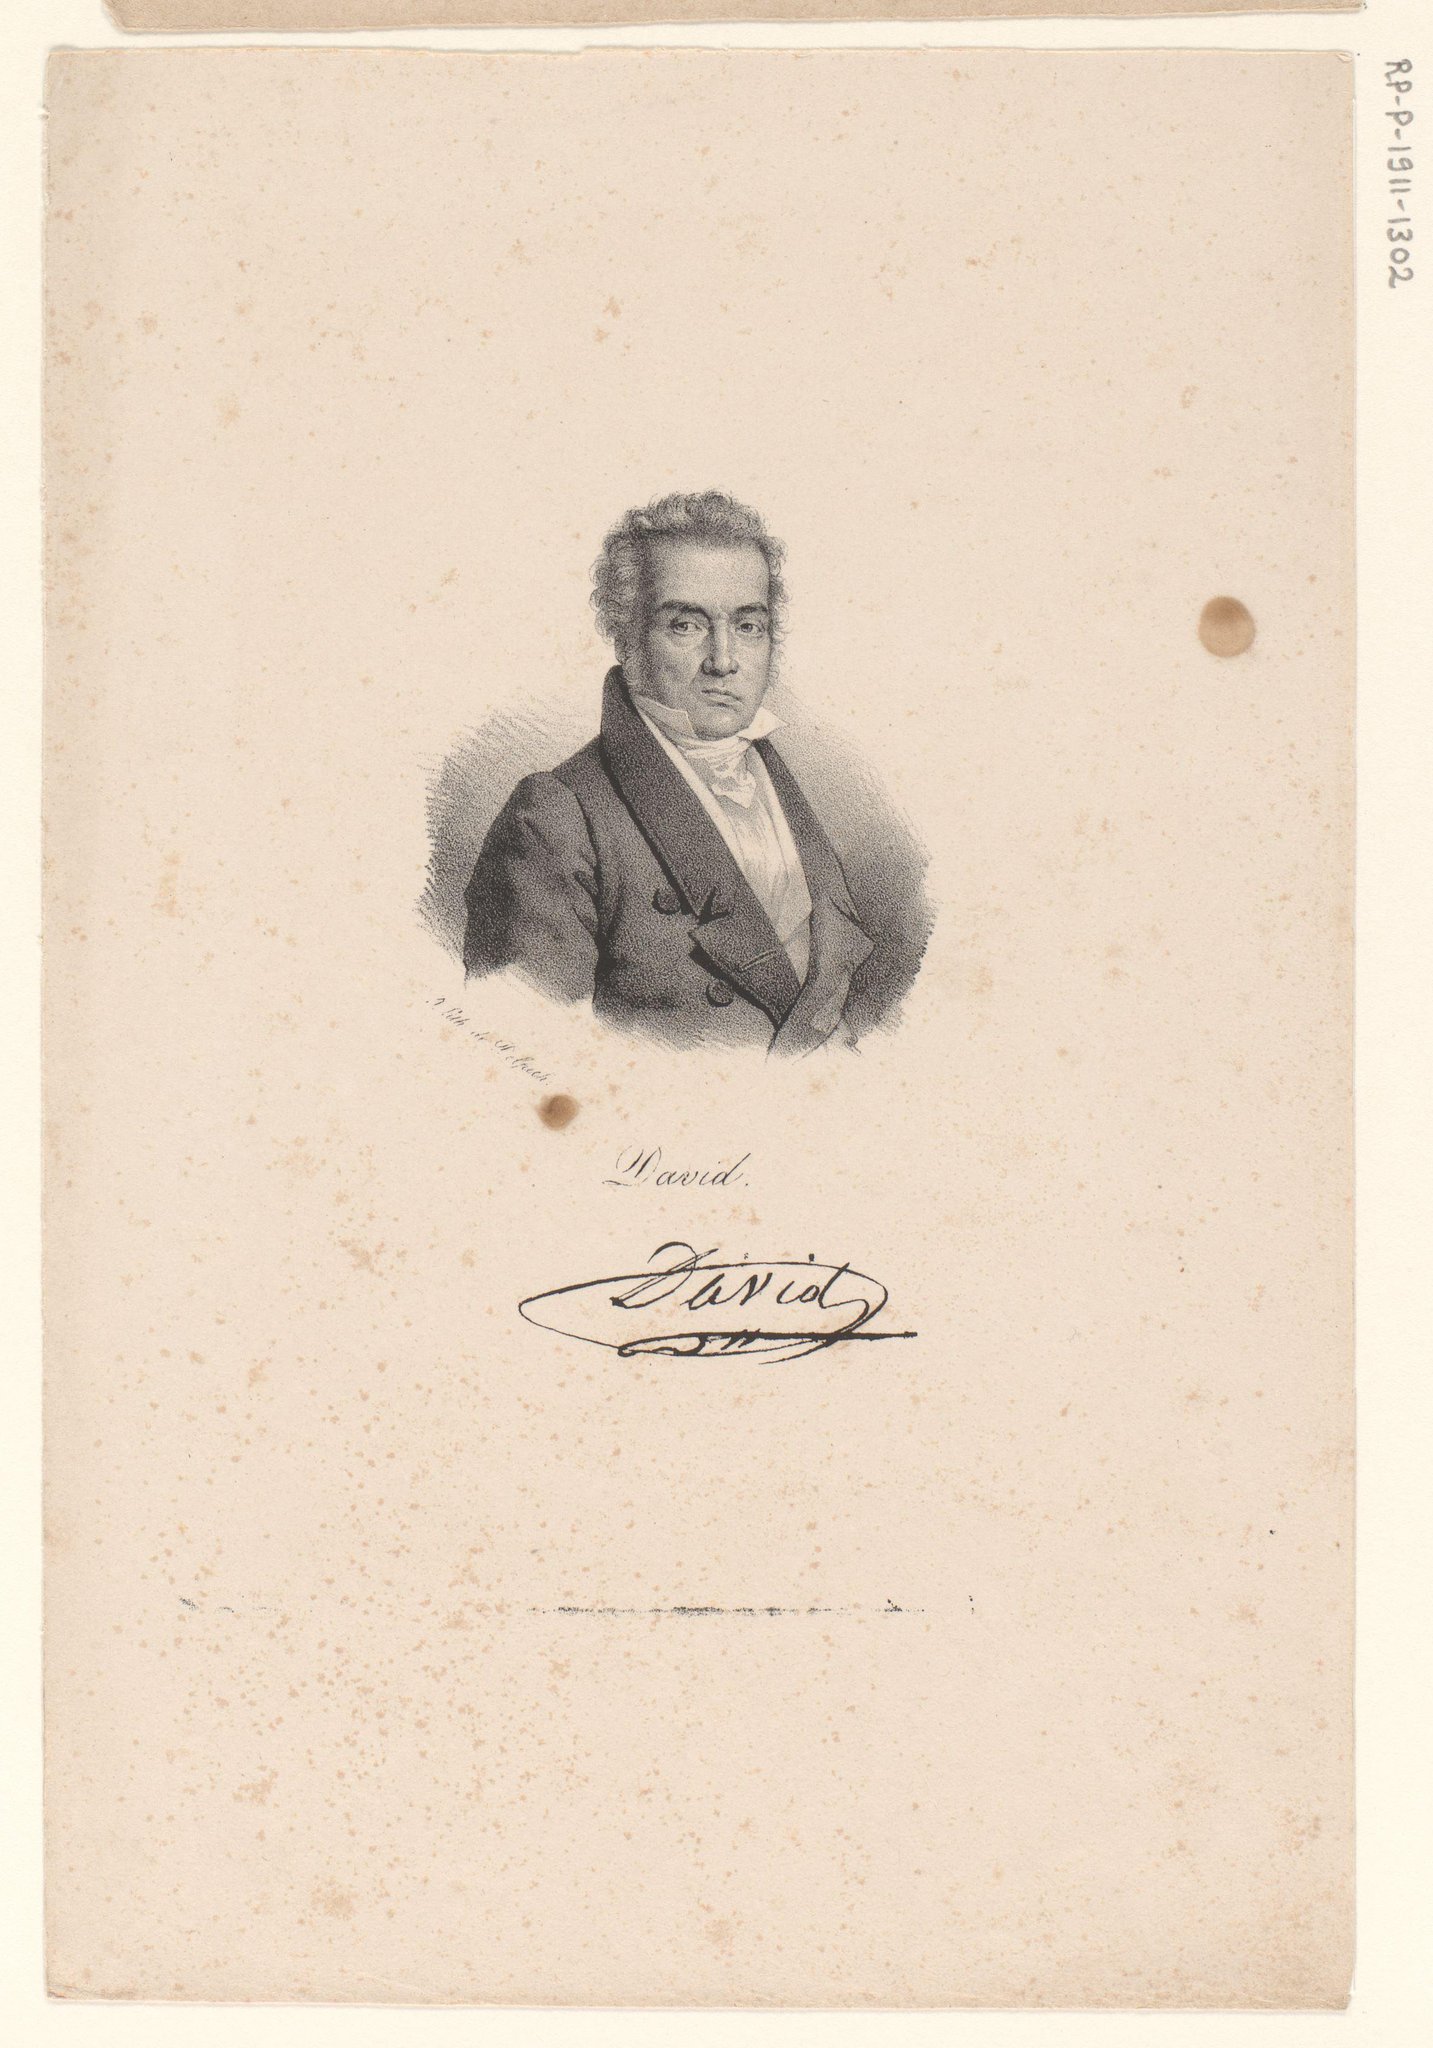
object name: print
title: David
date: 1818-1842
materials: paper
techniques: lithograph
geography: paris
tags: paris, brussels, painter, jacques-louis david, historical persons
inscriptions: collector's mark: Lugt 2228a